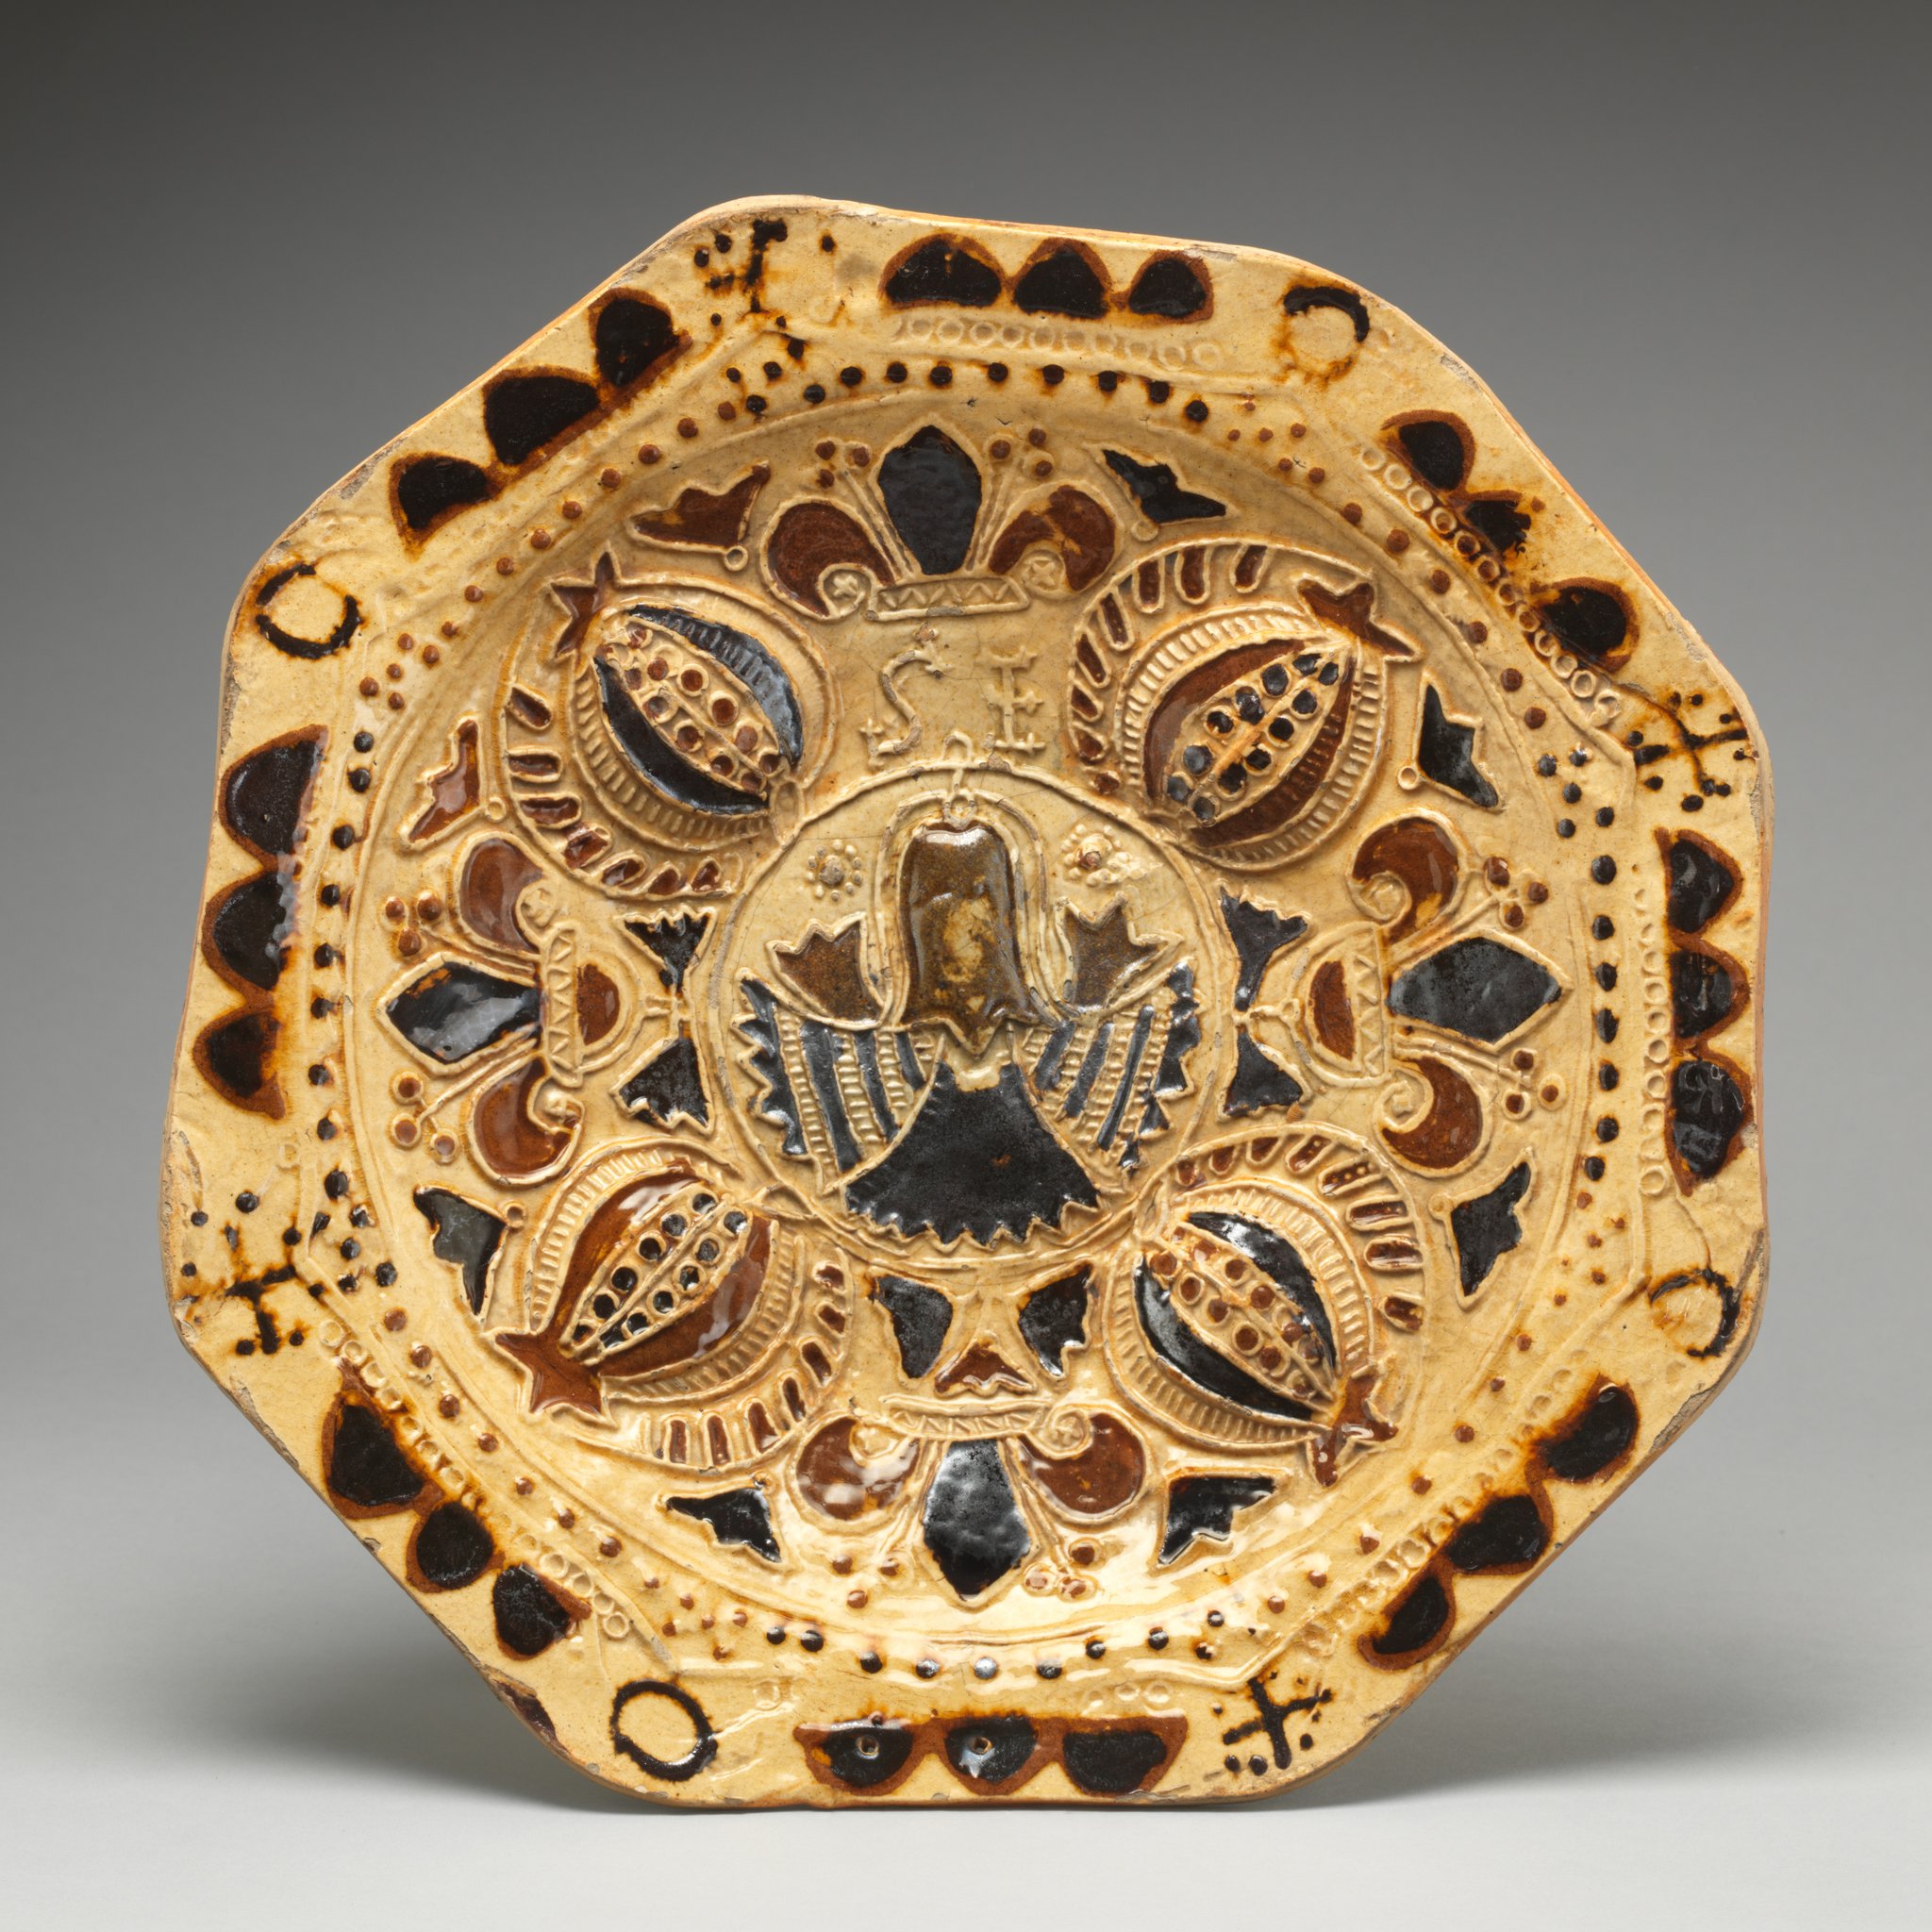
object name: dish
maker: john simpson iii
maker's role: maker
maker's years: 1685-1775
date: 1715